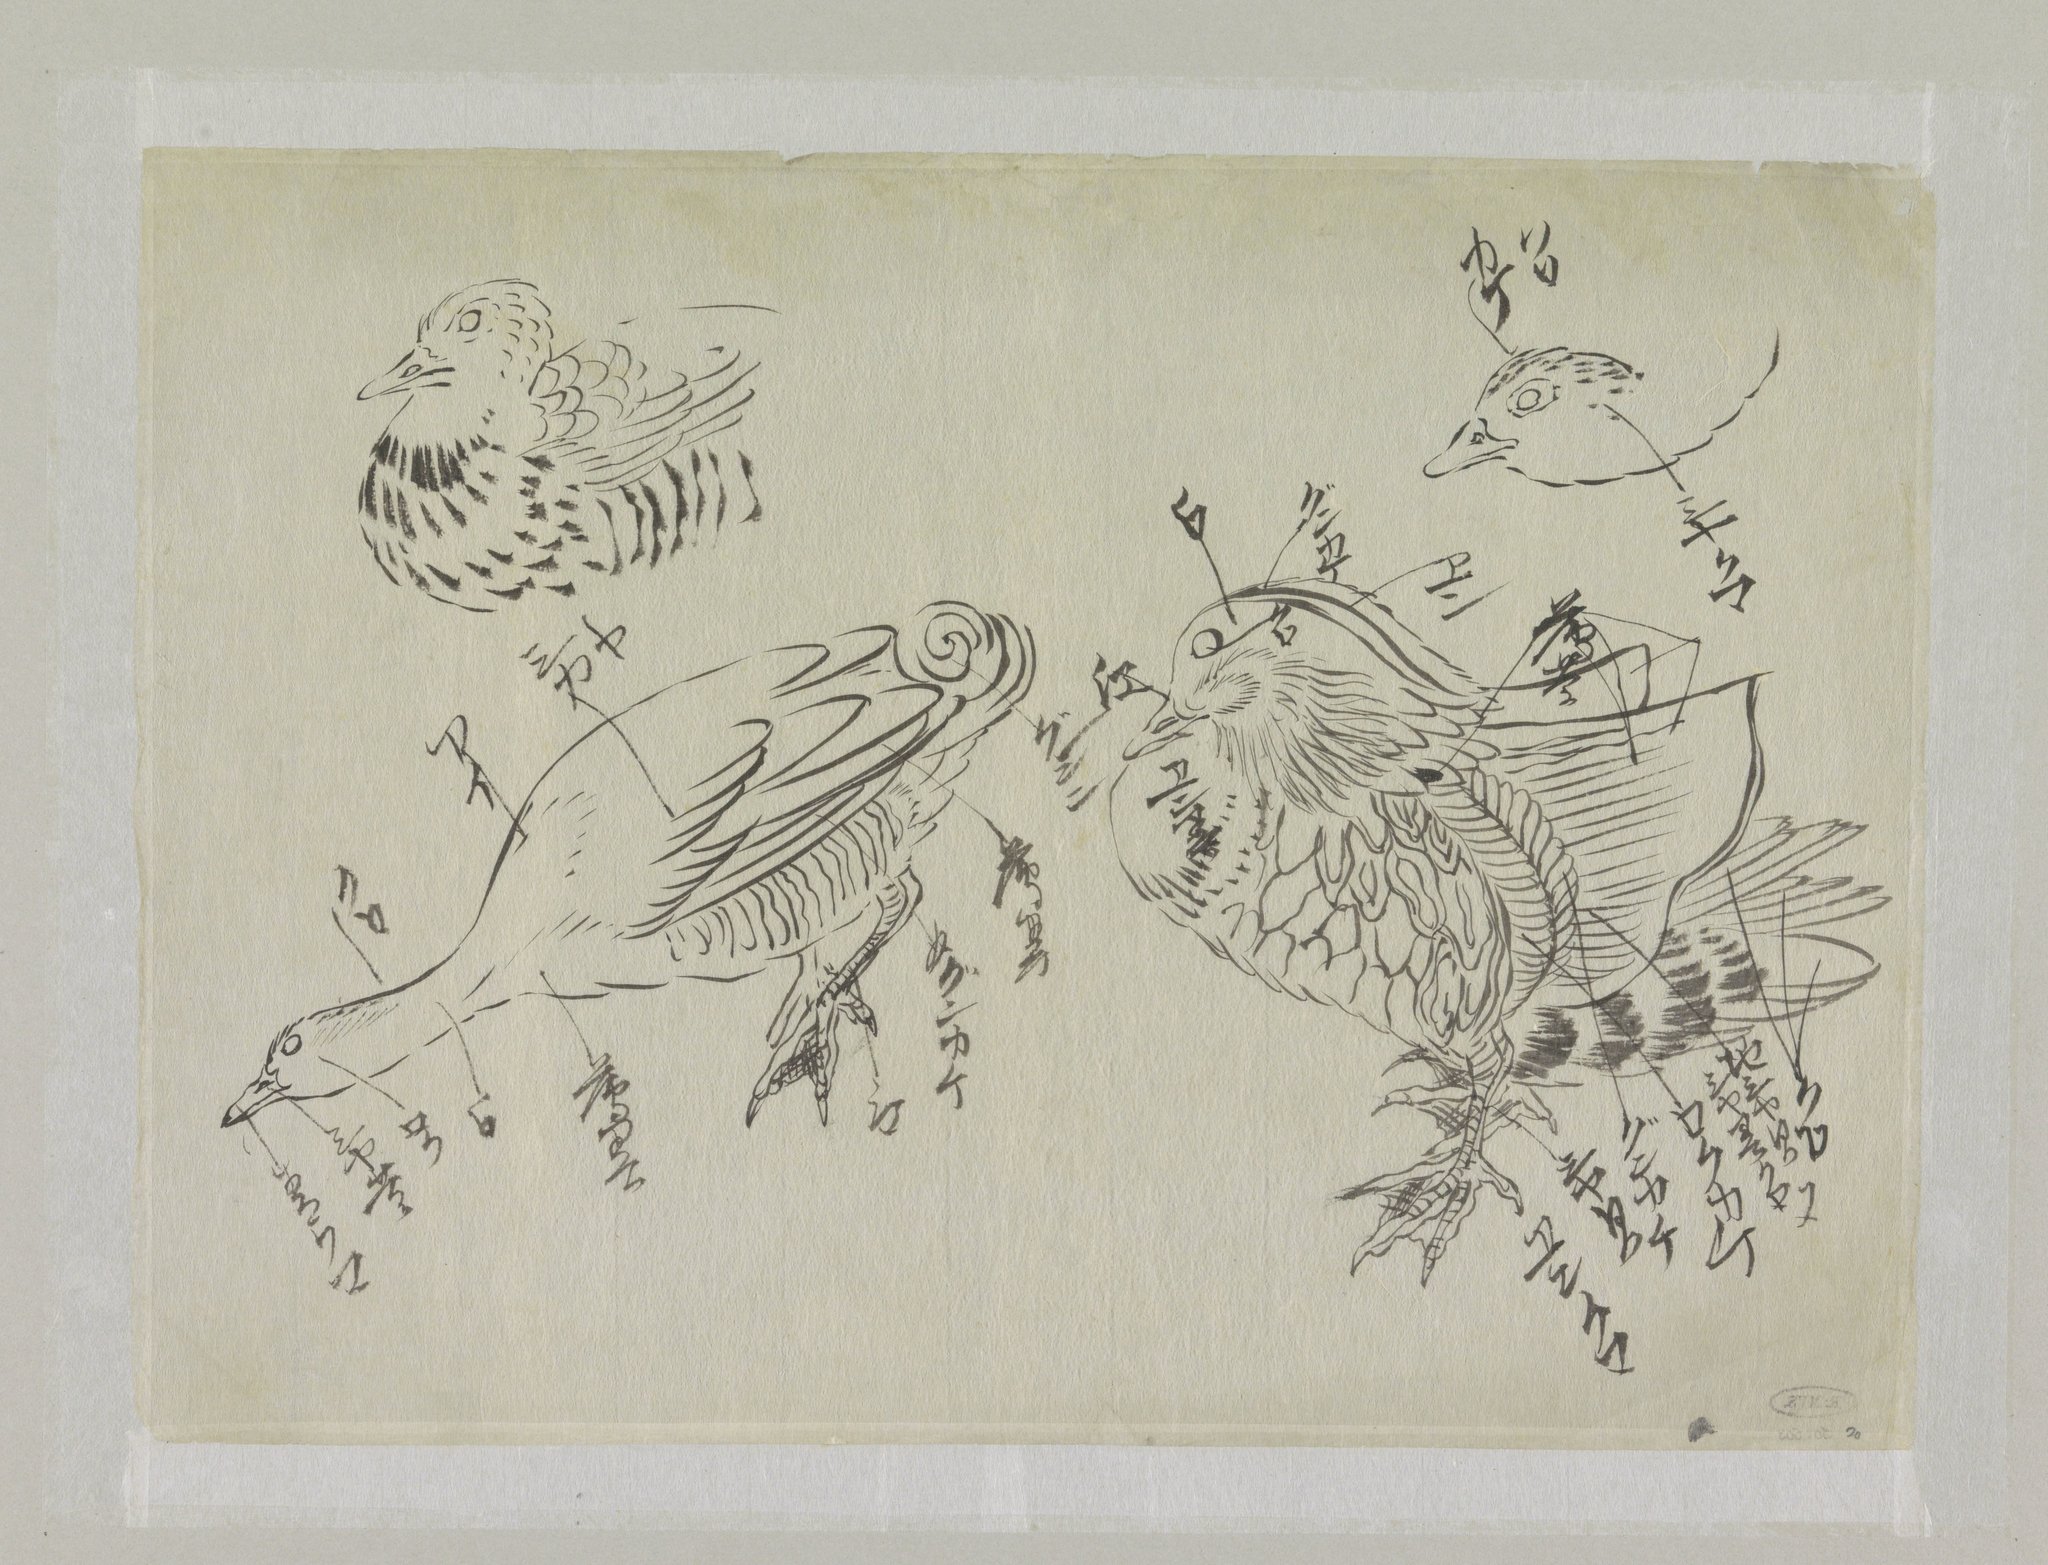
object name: drawing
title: Schetsblad met eendenstudies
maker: ishikawa kazan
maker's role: draughtsman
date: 1800-1900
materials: paper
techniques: brush